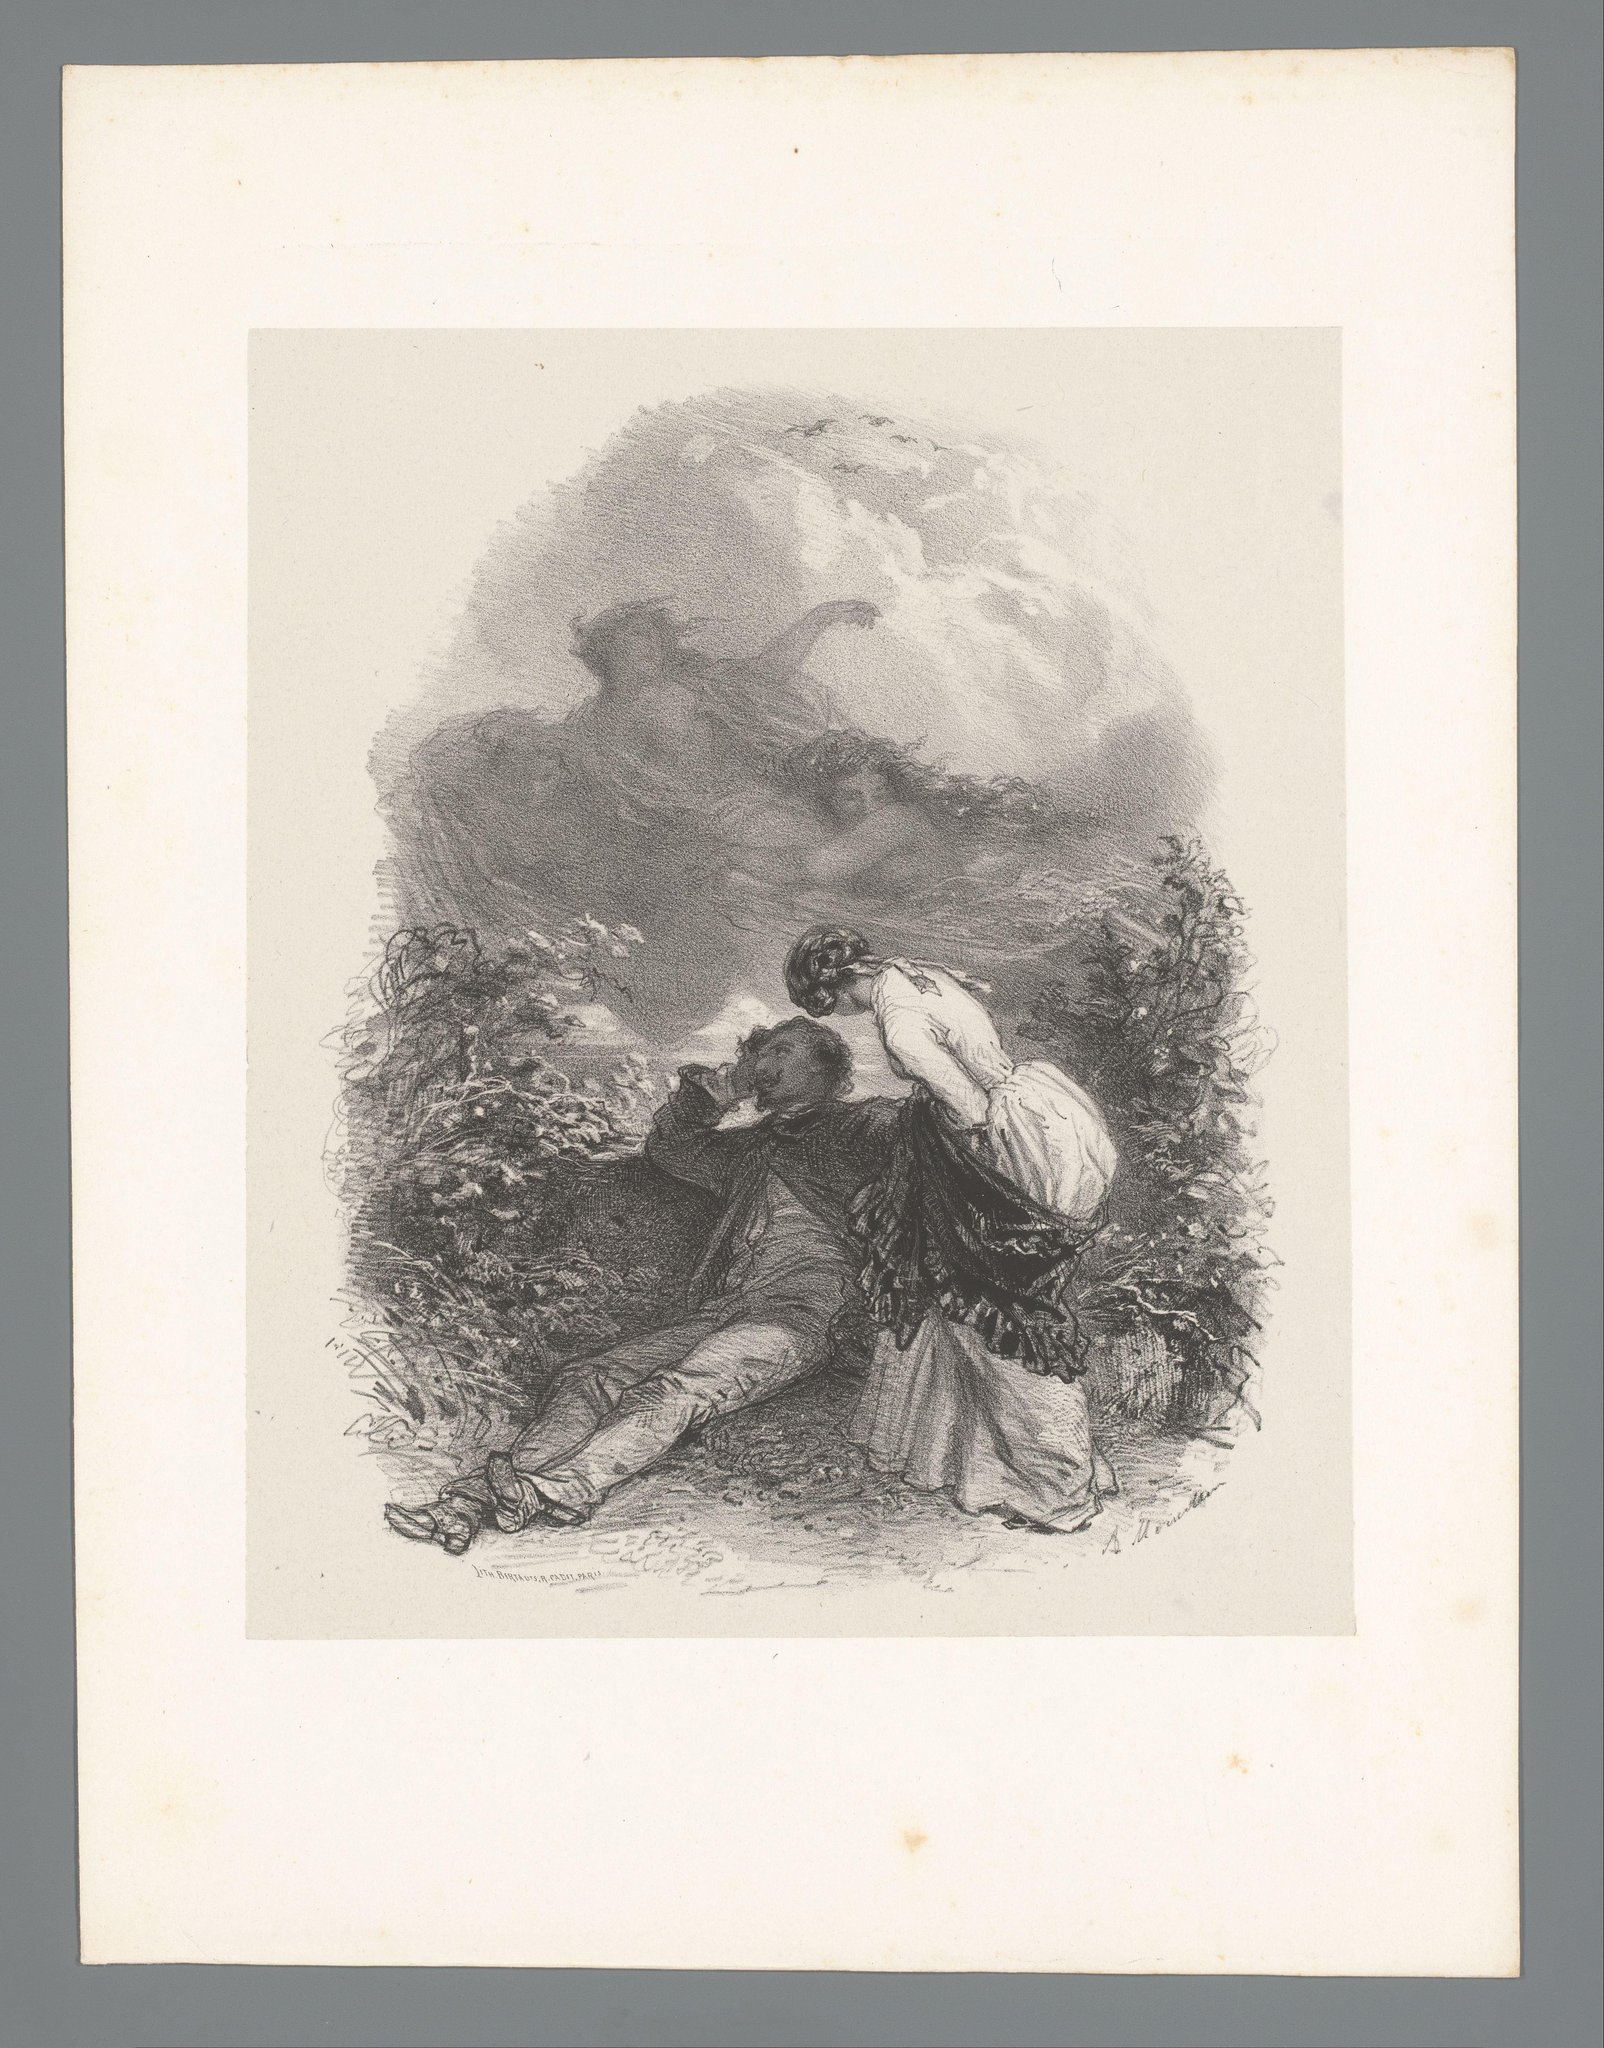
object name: print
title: Vrouw buigt zich buiten over dromende man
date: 1851-1865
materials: paper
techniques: lithograph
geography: paris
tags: adult woman, adult man, dream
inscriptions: collector's mark: Lugt 964